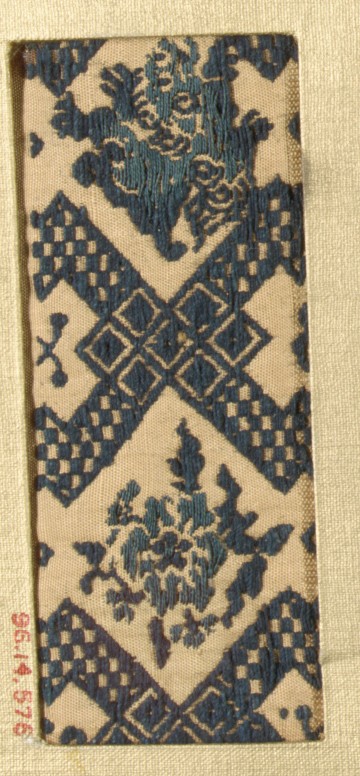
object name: piece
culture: japanese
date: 1701-1900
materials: silk